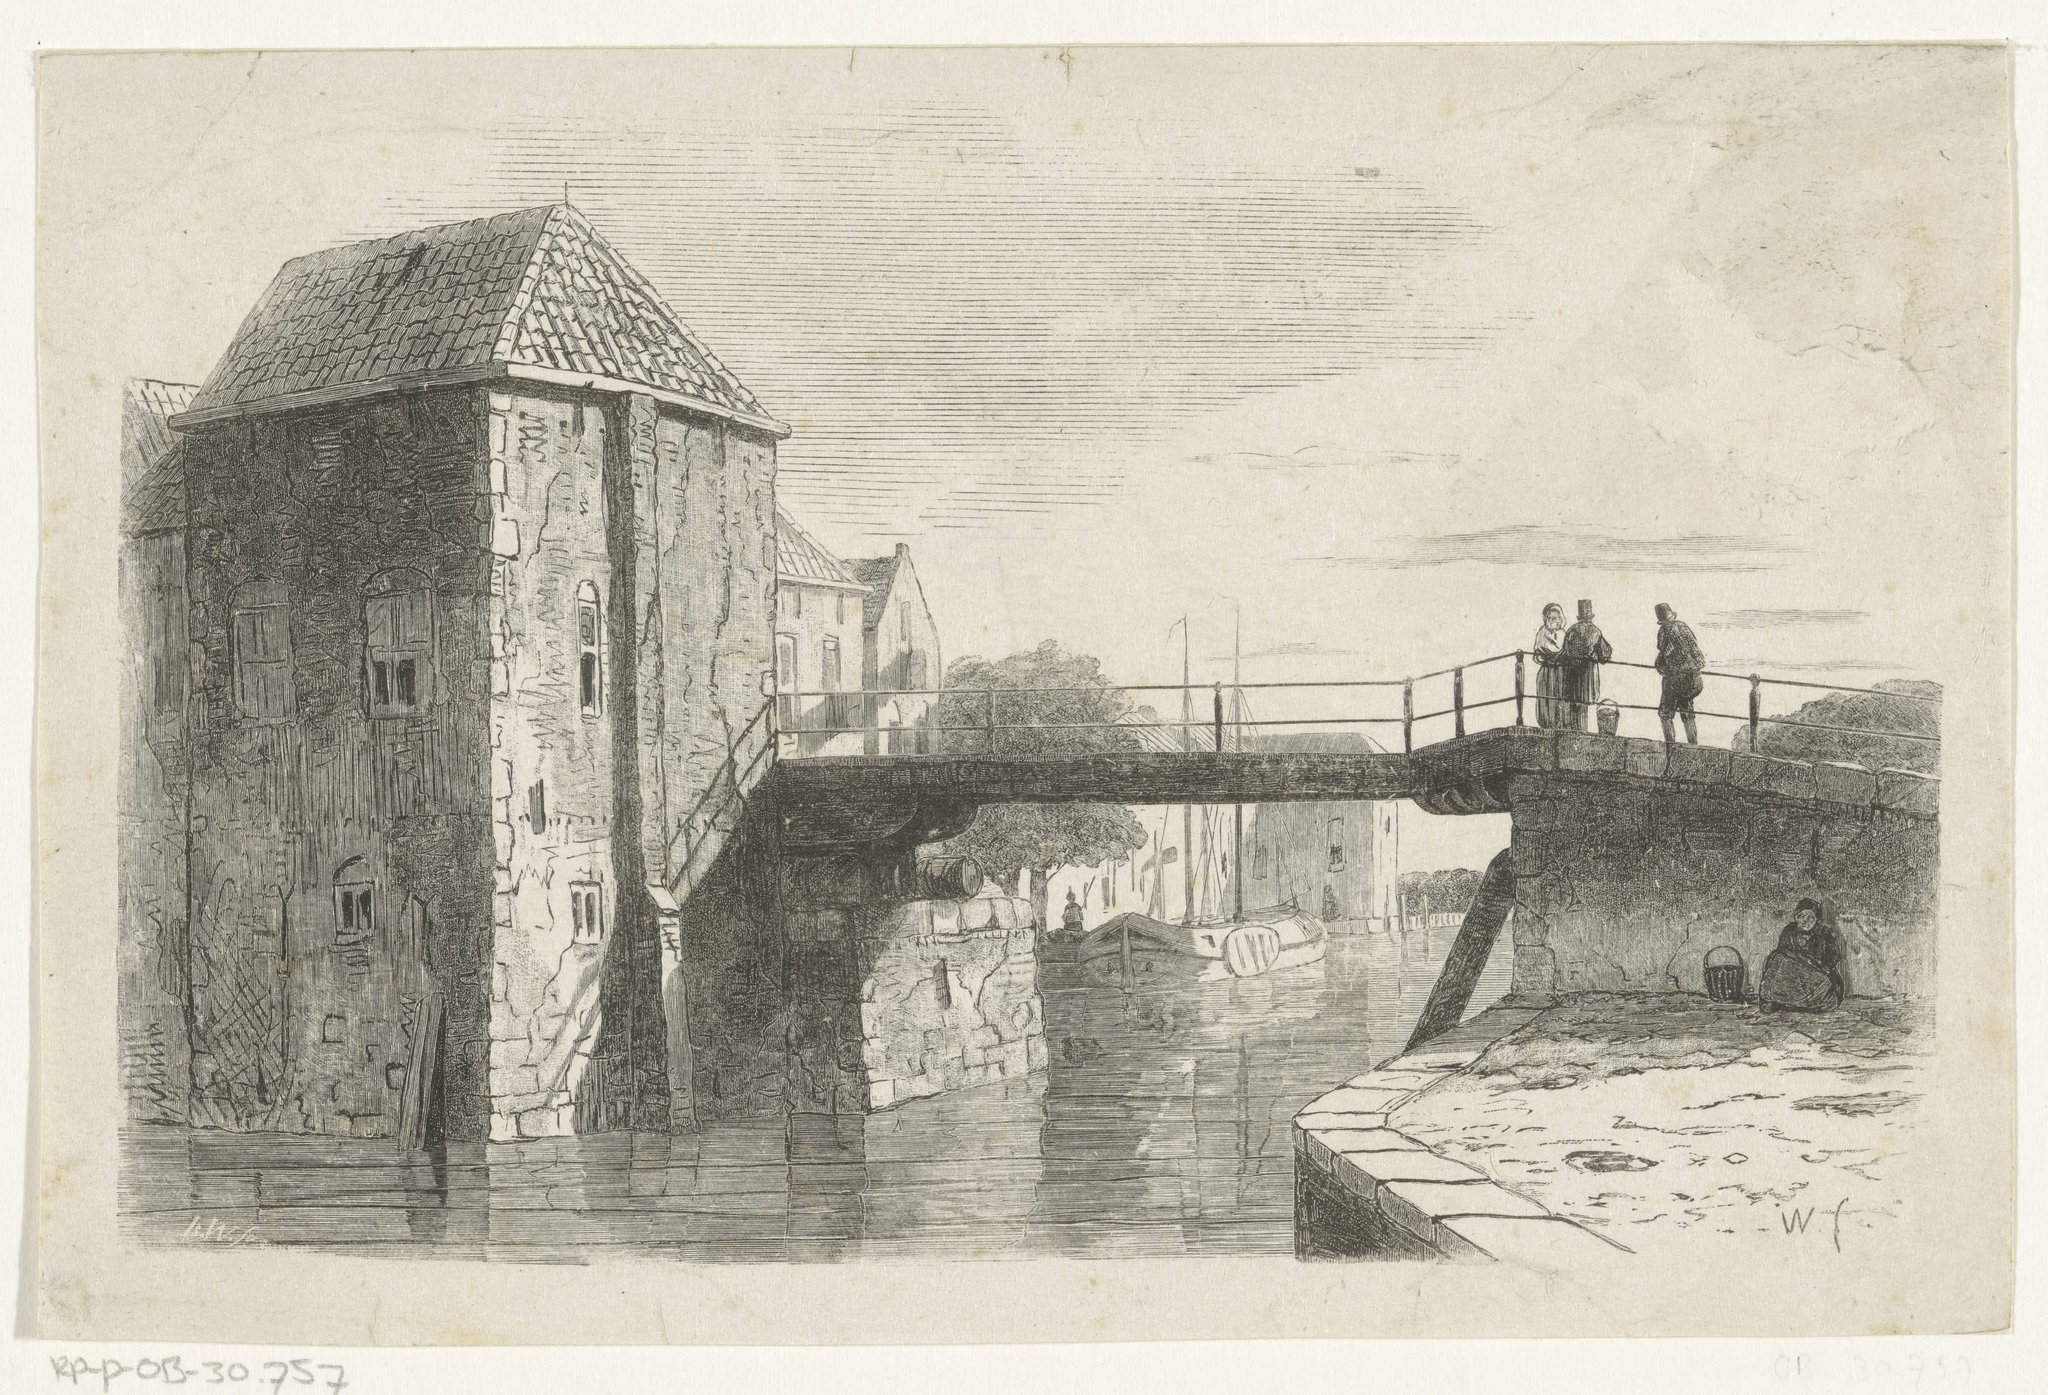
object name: print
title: Stadsgezicht met figuren op een brug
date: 1836-1912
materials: paper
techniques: engraving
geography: netherlands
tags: bridge in city across river, canal, etc. (+ city(-scape) with figures, staffage)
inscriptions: collector's mark: Lugt 2228